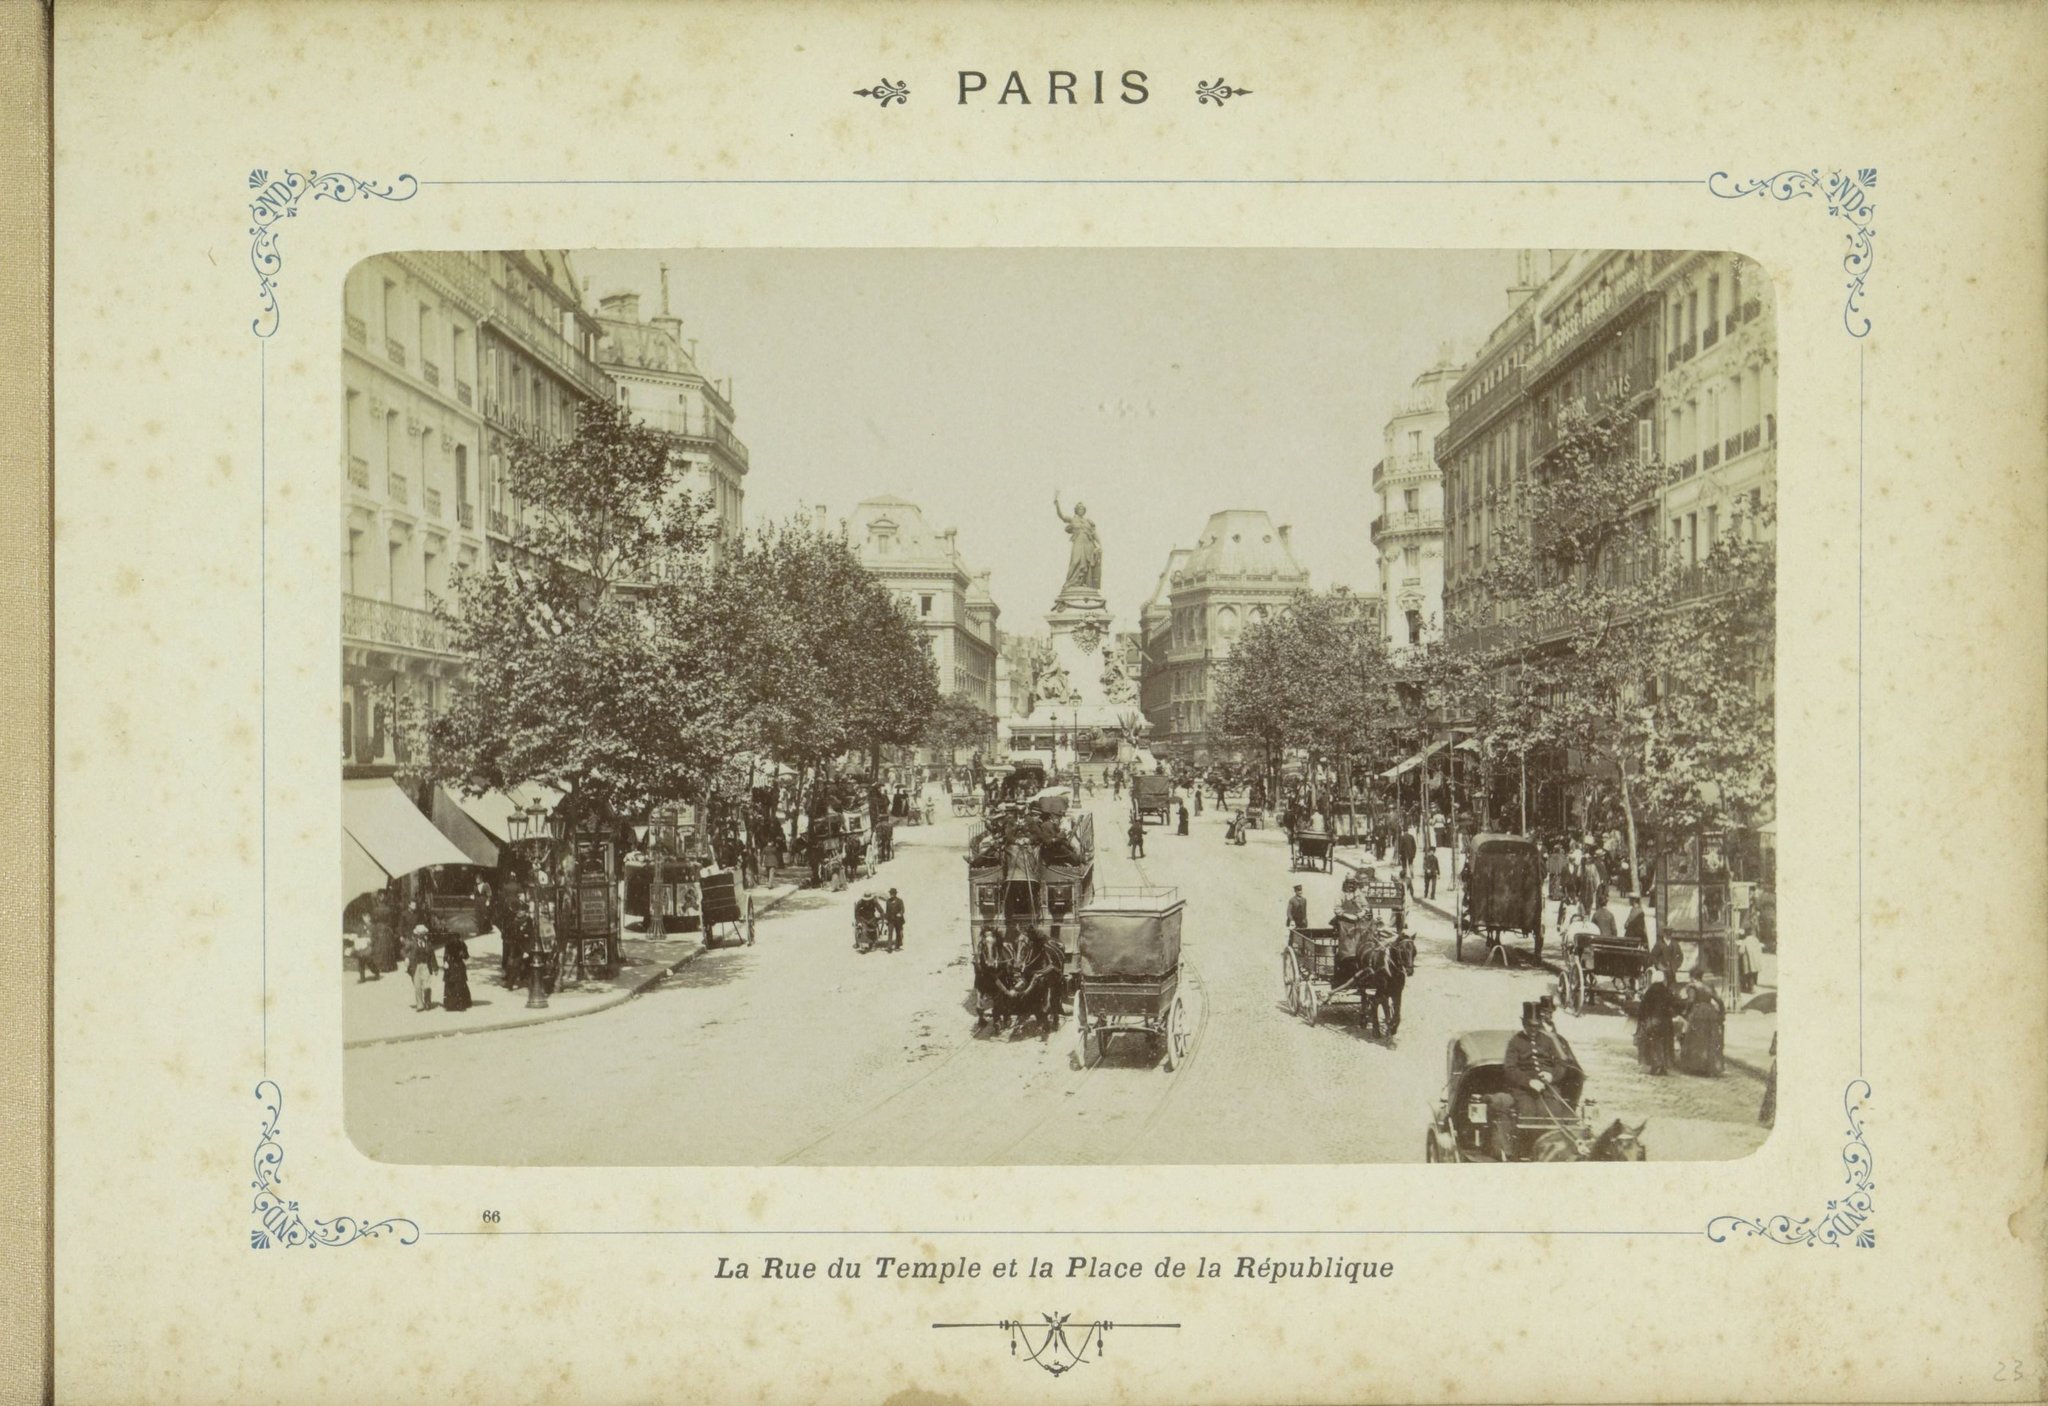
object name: photograph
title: Paris - La Rue du Temple et la Place de la République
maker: Anonymous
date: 1900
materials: cardboard, paper, photographic support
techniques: albumen print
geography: paris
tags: diligence, omnibus, horse-tram, four-wheeled, animal-drawn vehicle, e.g.: cab, carriage, coach (+ conveyance for transport of persons), monument, statue, square, place, circus, etc. (+ city(-scape) with figures, staffage), paris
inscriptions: number: ‘66’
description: Onderdeel van Fotoalbum met bezienswaardigheden in Parijs, Versailles en het Bois de Boulogne.